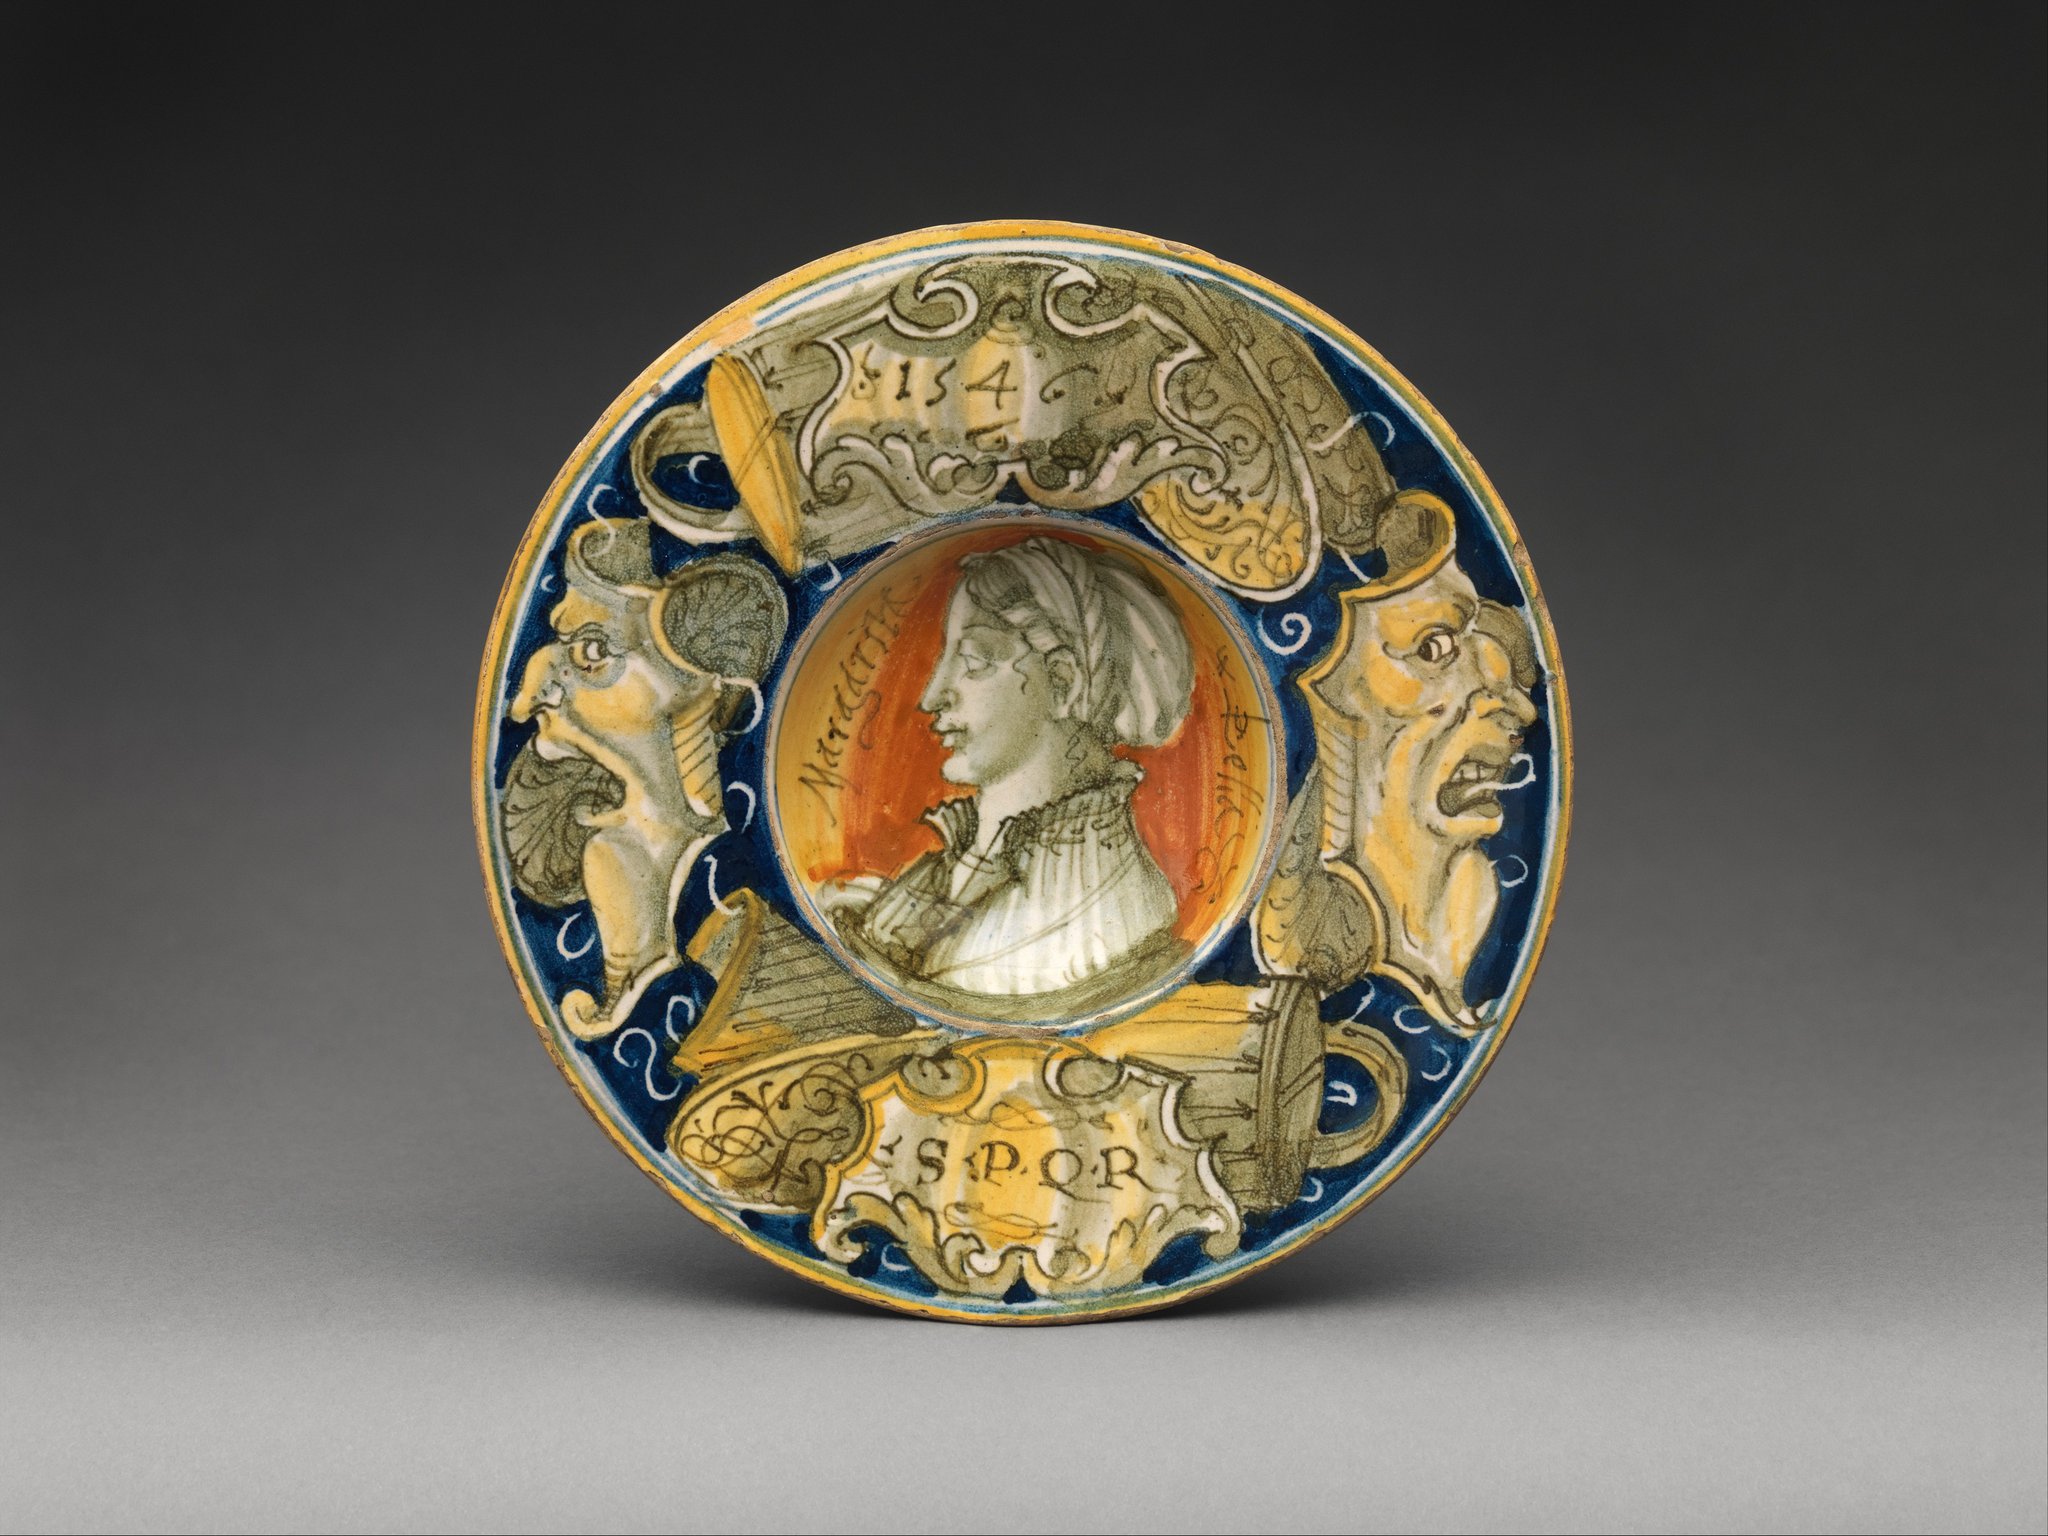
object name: bowl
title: Wide-rimmed bowl with Beautiful Margarita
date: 1546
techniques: maiolica, glazing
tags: profiles,women